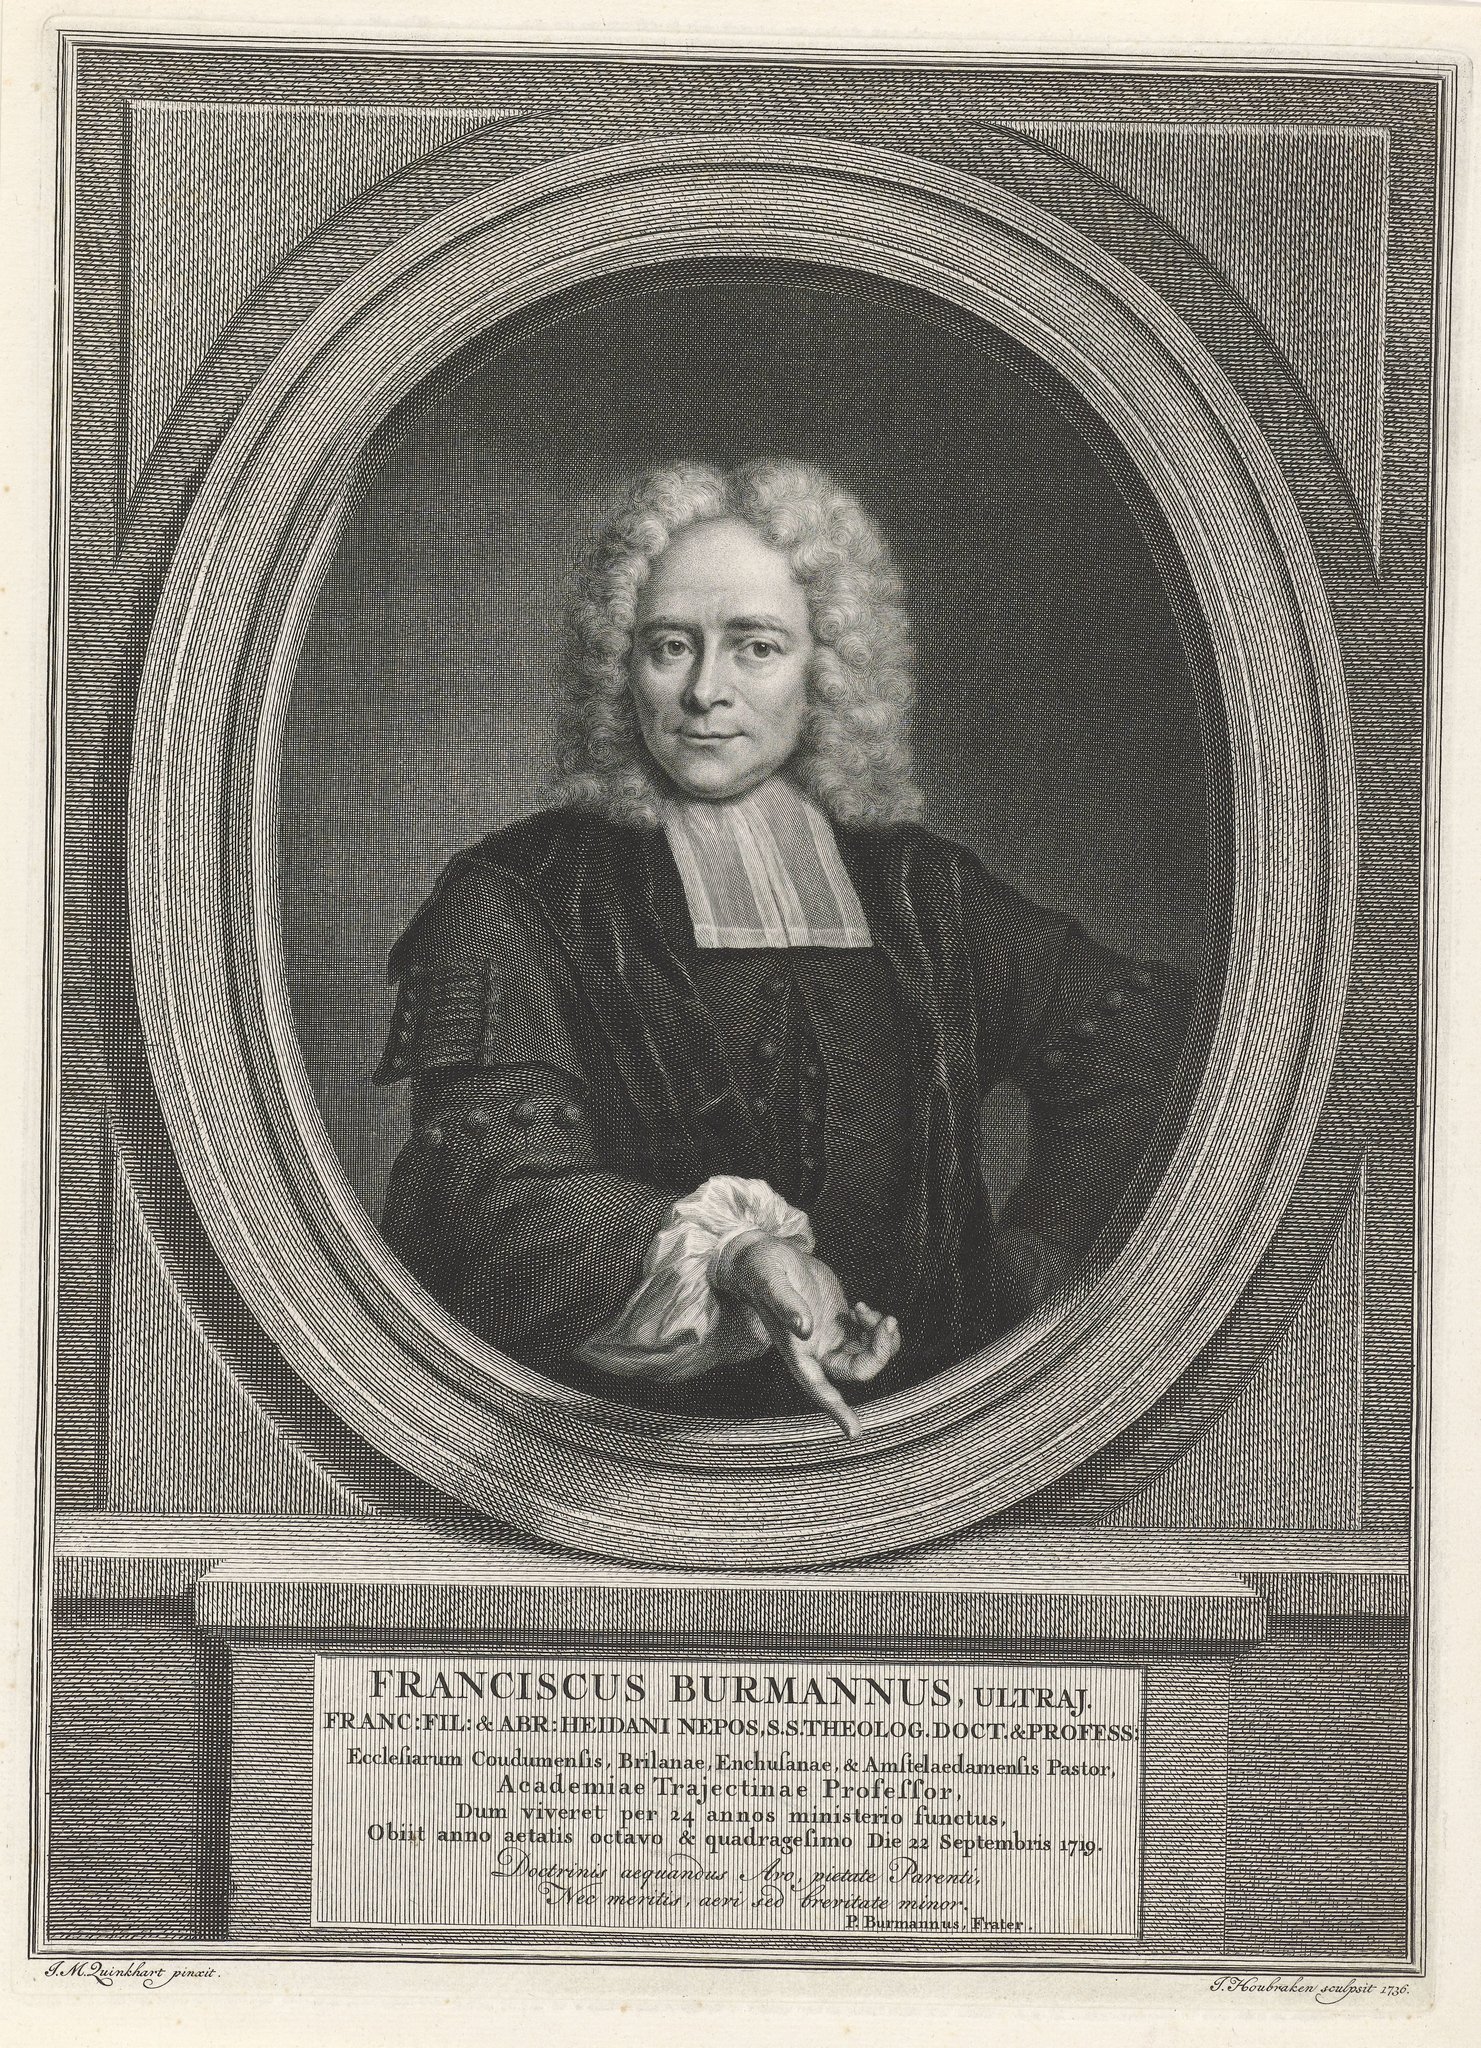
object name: print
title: Franciscus Burmannus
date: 1736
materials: paper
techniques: engraving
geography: amsterdam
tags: theoloog, hoogleraar, franciscus burman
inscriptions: collector's mark: Lugt 240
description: Portret ten halven lijve van Franciscus Burman in een ovale omlijsting, waarbij zijn rechterhand over de rand steekt. Het portret rust op een piëdestal waarop zijn naam en gegevens in zes regels in het Latijn. Daaronder een tweeregelig vers in het Latijn.